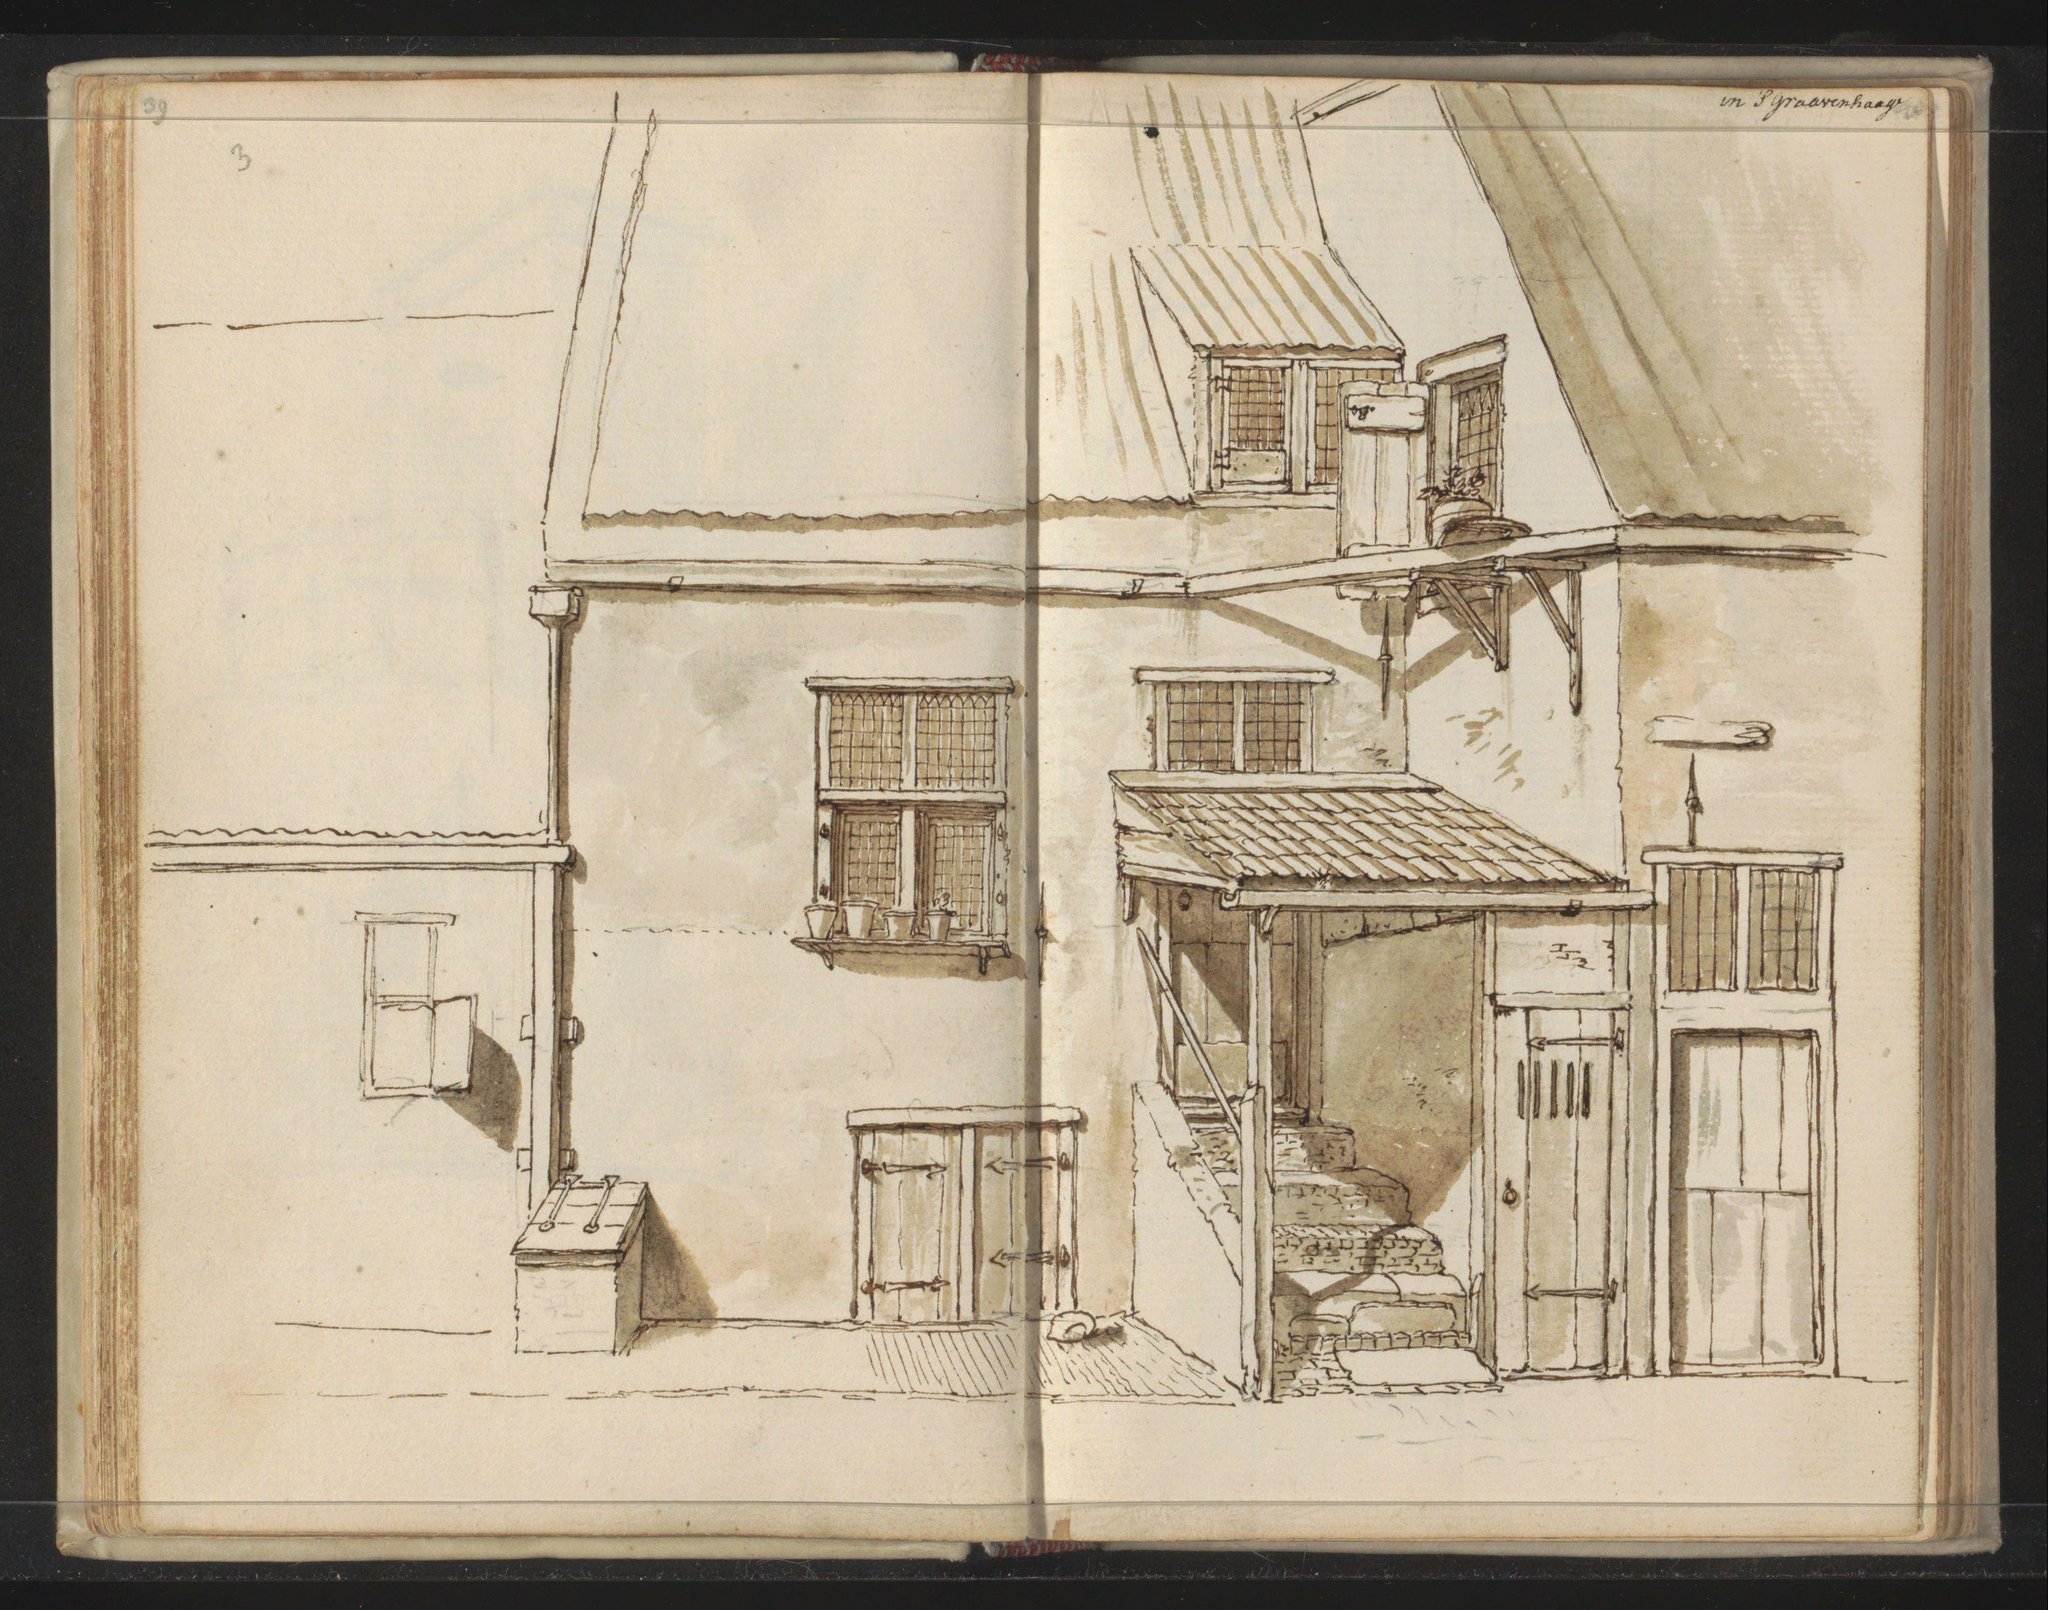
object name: sketchbook leaf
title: Gevel van een huis te Den Haag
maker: johannes huibert prins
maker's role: draughtsman, painter, print maker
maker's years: 1757-1806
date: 1783-1797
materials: ink, paper, pencil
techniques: brush, pen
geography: the hague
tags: façade (of house or building), front steps, the hague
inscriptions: annotation: ‘in 's gravenhage’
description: Pagina 39 en 40 uit een schetsboek met 175 pagina's.